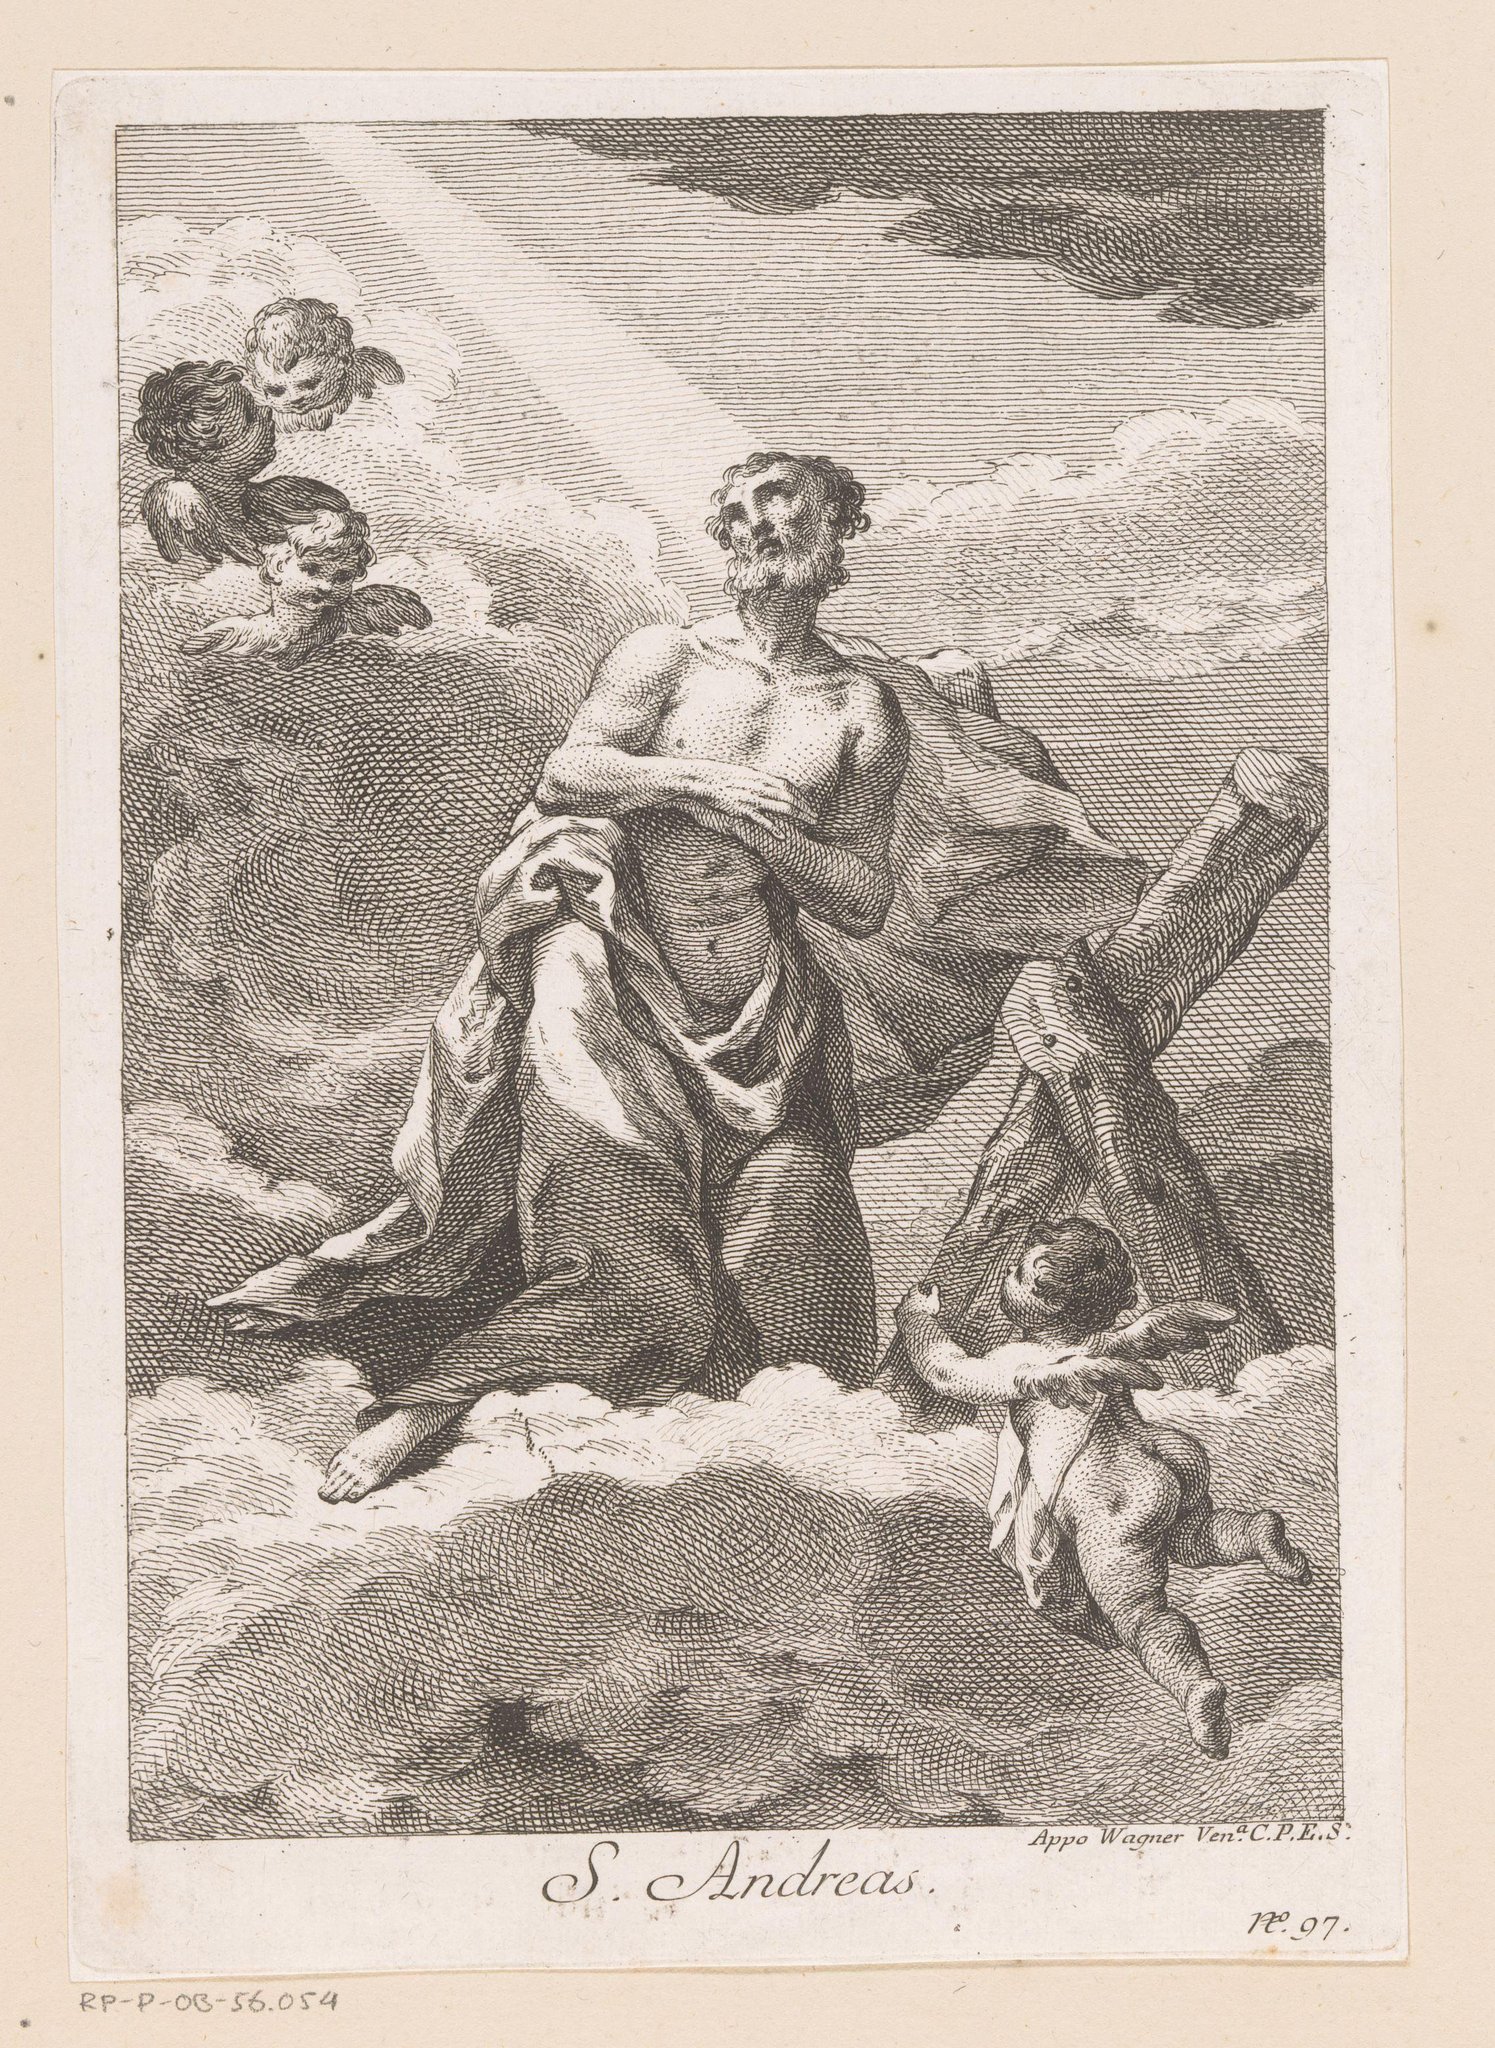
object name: print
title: S. Andreas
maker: joseph wagner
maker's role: painter, print maker, publisher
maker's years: 1706-1780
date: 1739-1780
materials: paper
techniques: etching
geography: venice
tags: the apostle andrew; possible attributes: book, x-shaped cross, fish, fishing-net, rope, scroll